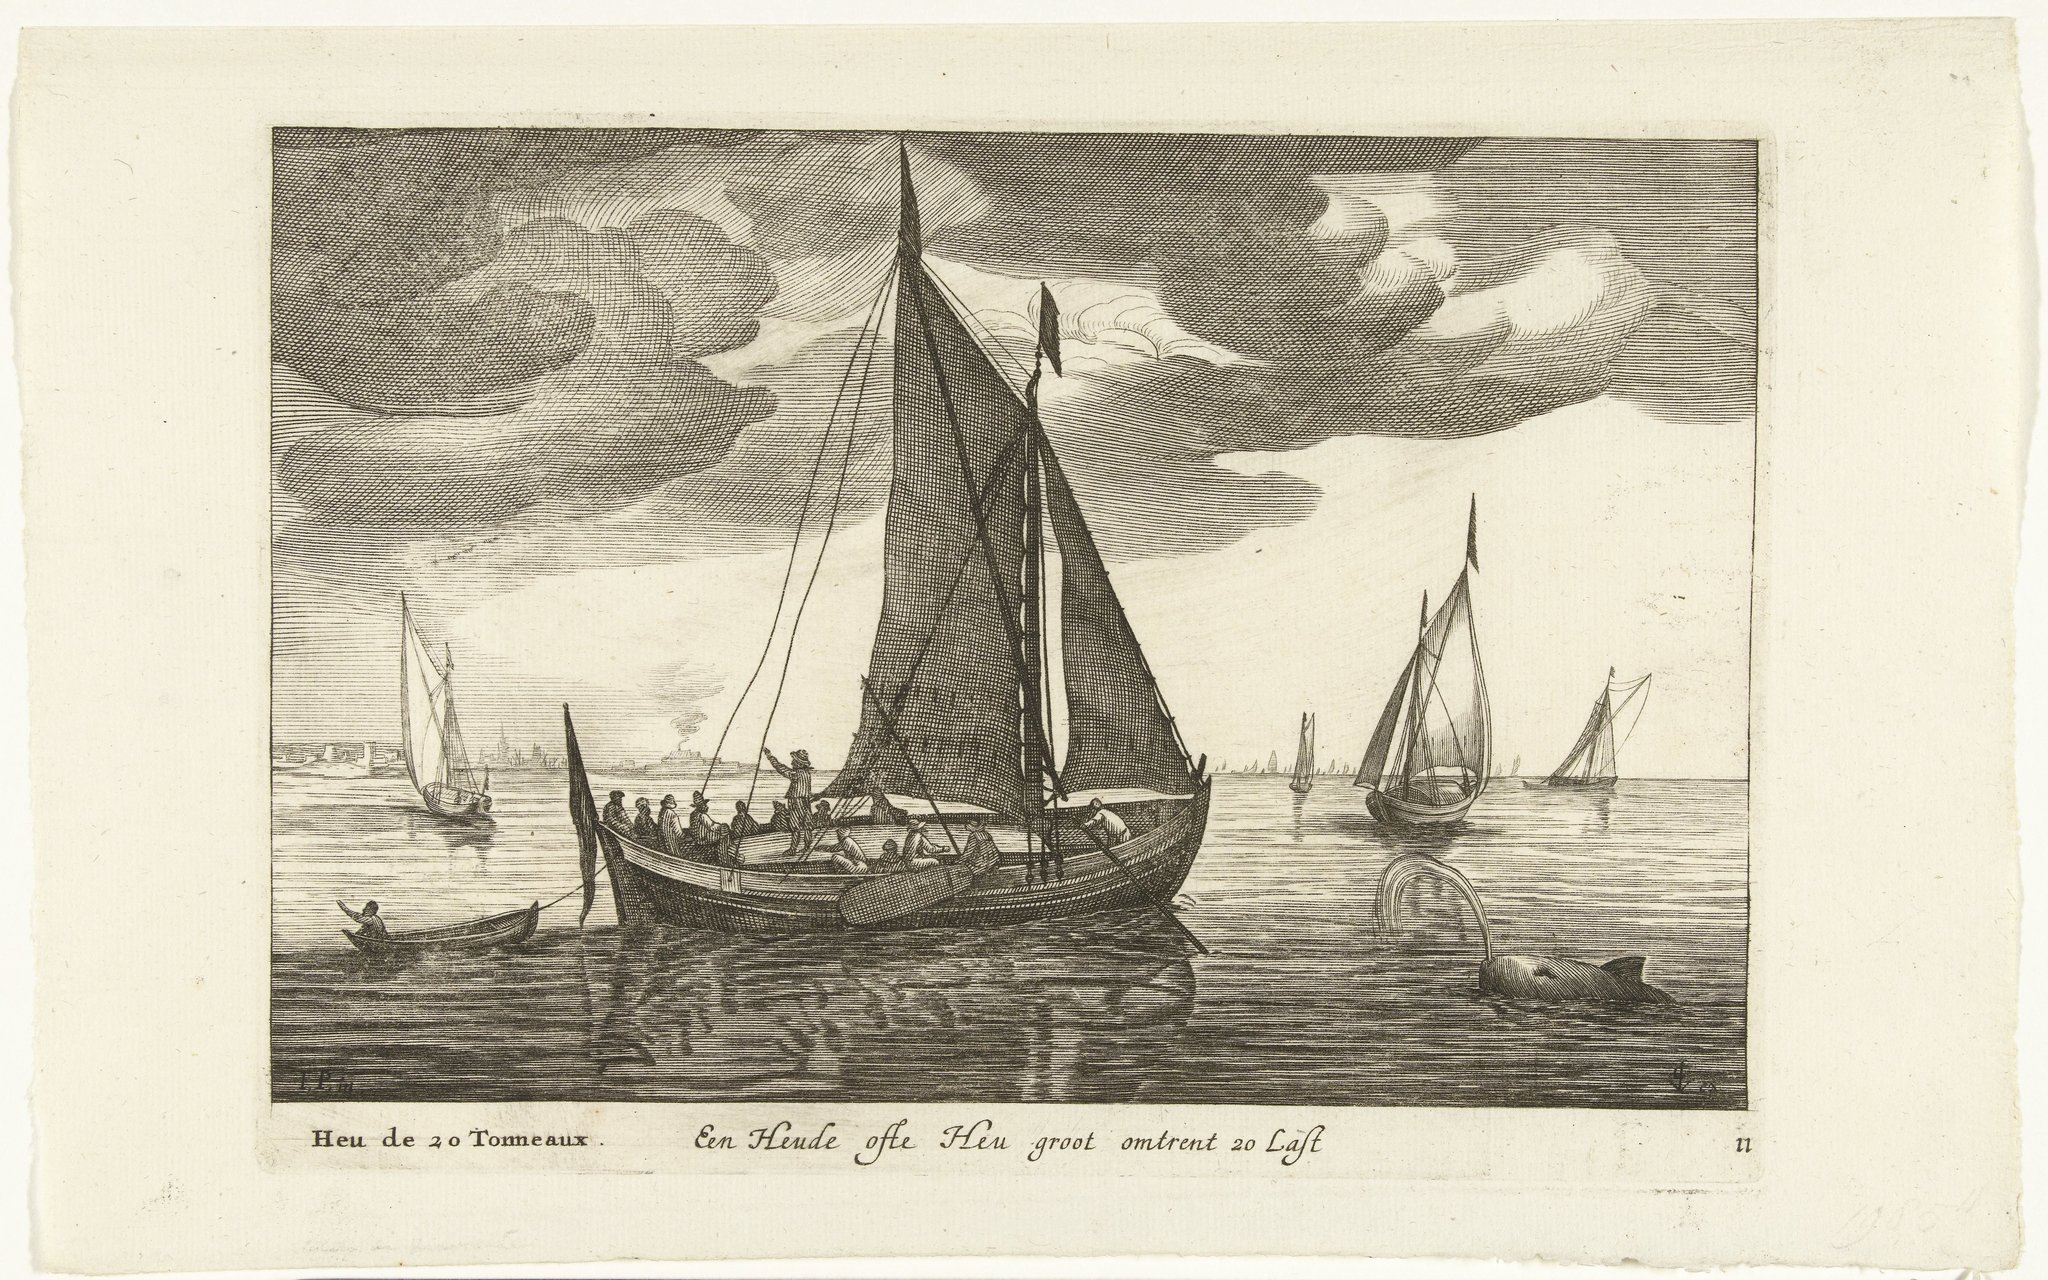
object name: print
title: Een Heude ofte Heu groot omtrent 20 Last / Heu de 20 Tonneaux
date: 1627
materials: paper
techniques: engraving, etching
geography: northern netherlands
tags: sailing-ship, sailing-boat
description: Een heude of heu op het water. Prent nr. 11 in een serie prenten van Hollandse scheepstypen, 1627. .